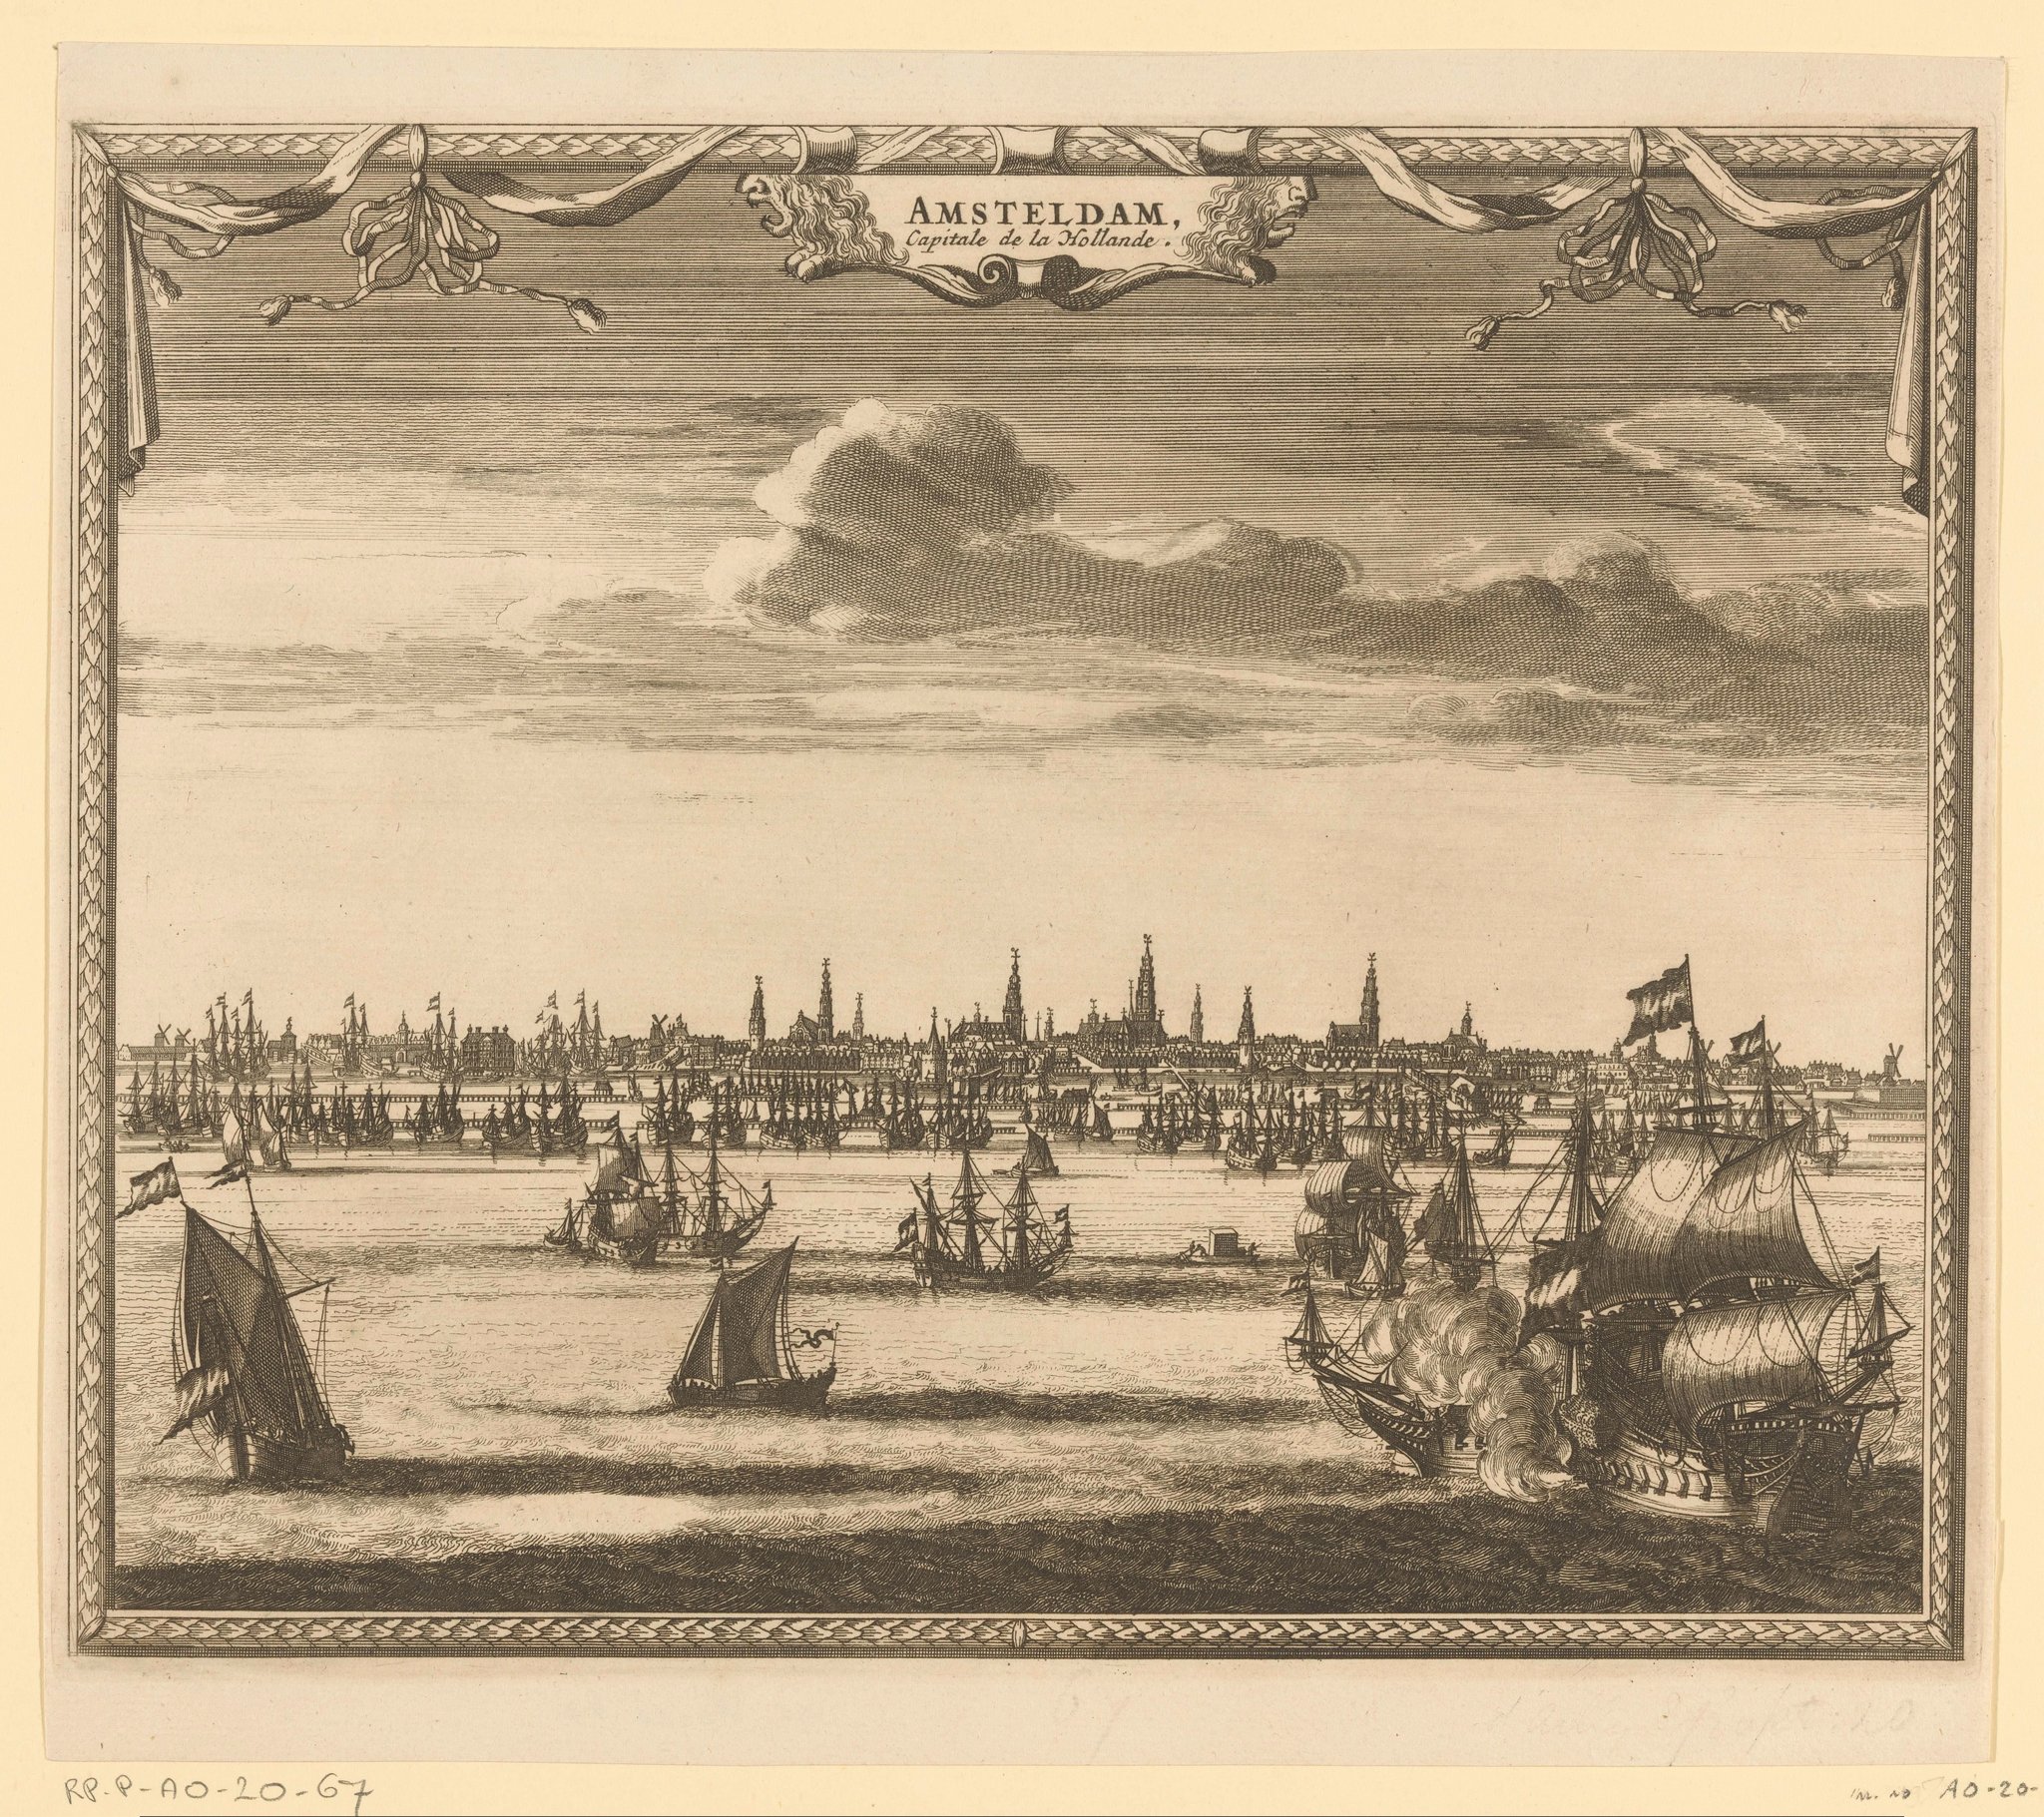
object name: print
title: Gezicht op Amsterdam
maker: Anonymous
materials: paper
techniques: etching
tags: prospect of city, town panorama, silhouette of city, amsterdam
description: Huidige staat van prent ook gebruikt in: Aa, Pieter van der. Europa. Leiden: Pieter van der Aa, s.a. [ca. 1715]. En in: Afbeeldinghe der voornaemste steeden van Nederlant / Les principales villes des Pais-bas. Amsteram: Covens & Mortier, s.a. [na 1721]. En in: Les forces de l'Europe, Asie, Afrique et Amerique, ou description des principales villes, avec leurs fortifications (…). 20 delen. Leiden : Pieter van der Aa, 1726. Huidige staat met apart gedrukte sierrand gebruikt in: Aa, Pieter van der. La galerie agreable du monde (...). 66 delen. Leiden: Pieter van der Aa, 1728, dl. 17.